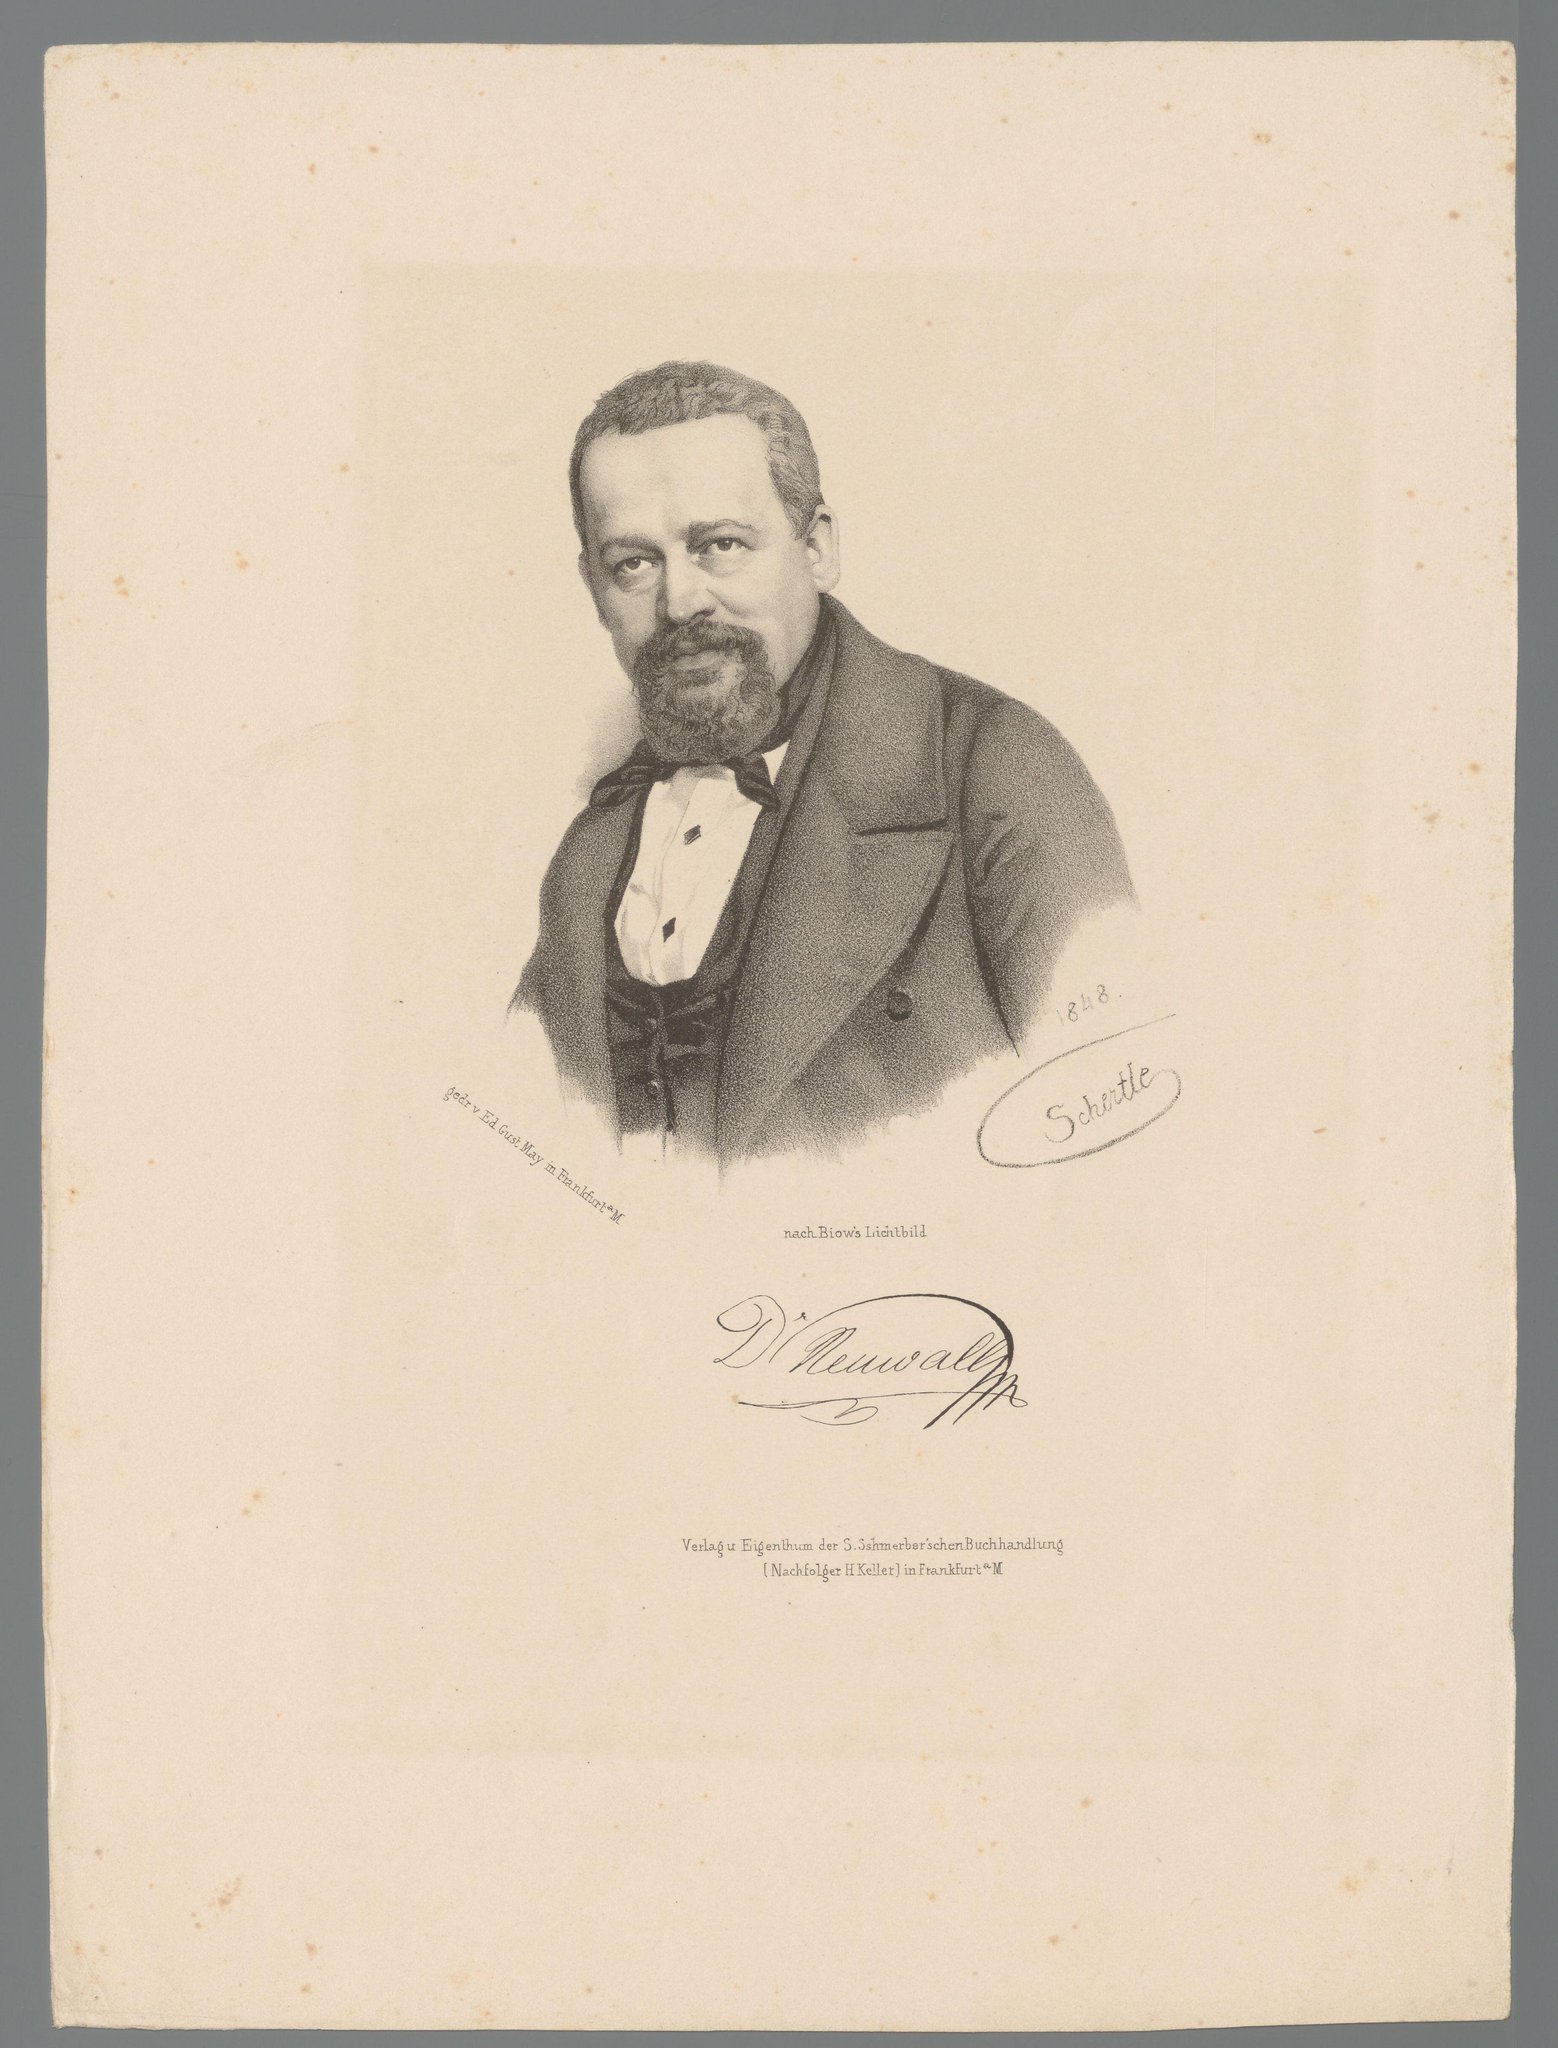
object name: print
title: Portret van Leopold von Neuwall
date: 1848-1849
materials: paper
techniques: lithograph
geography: frankfurt am main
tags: adult man, historical persons, beard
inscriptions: collector's mark: Lugt 2228